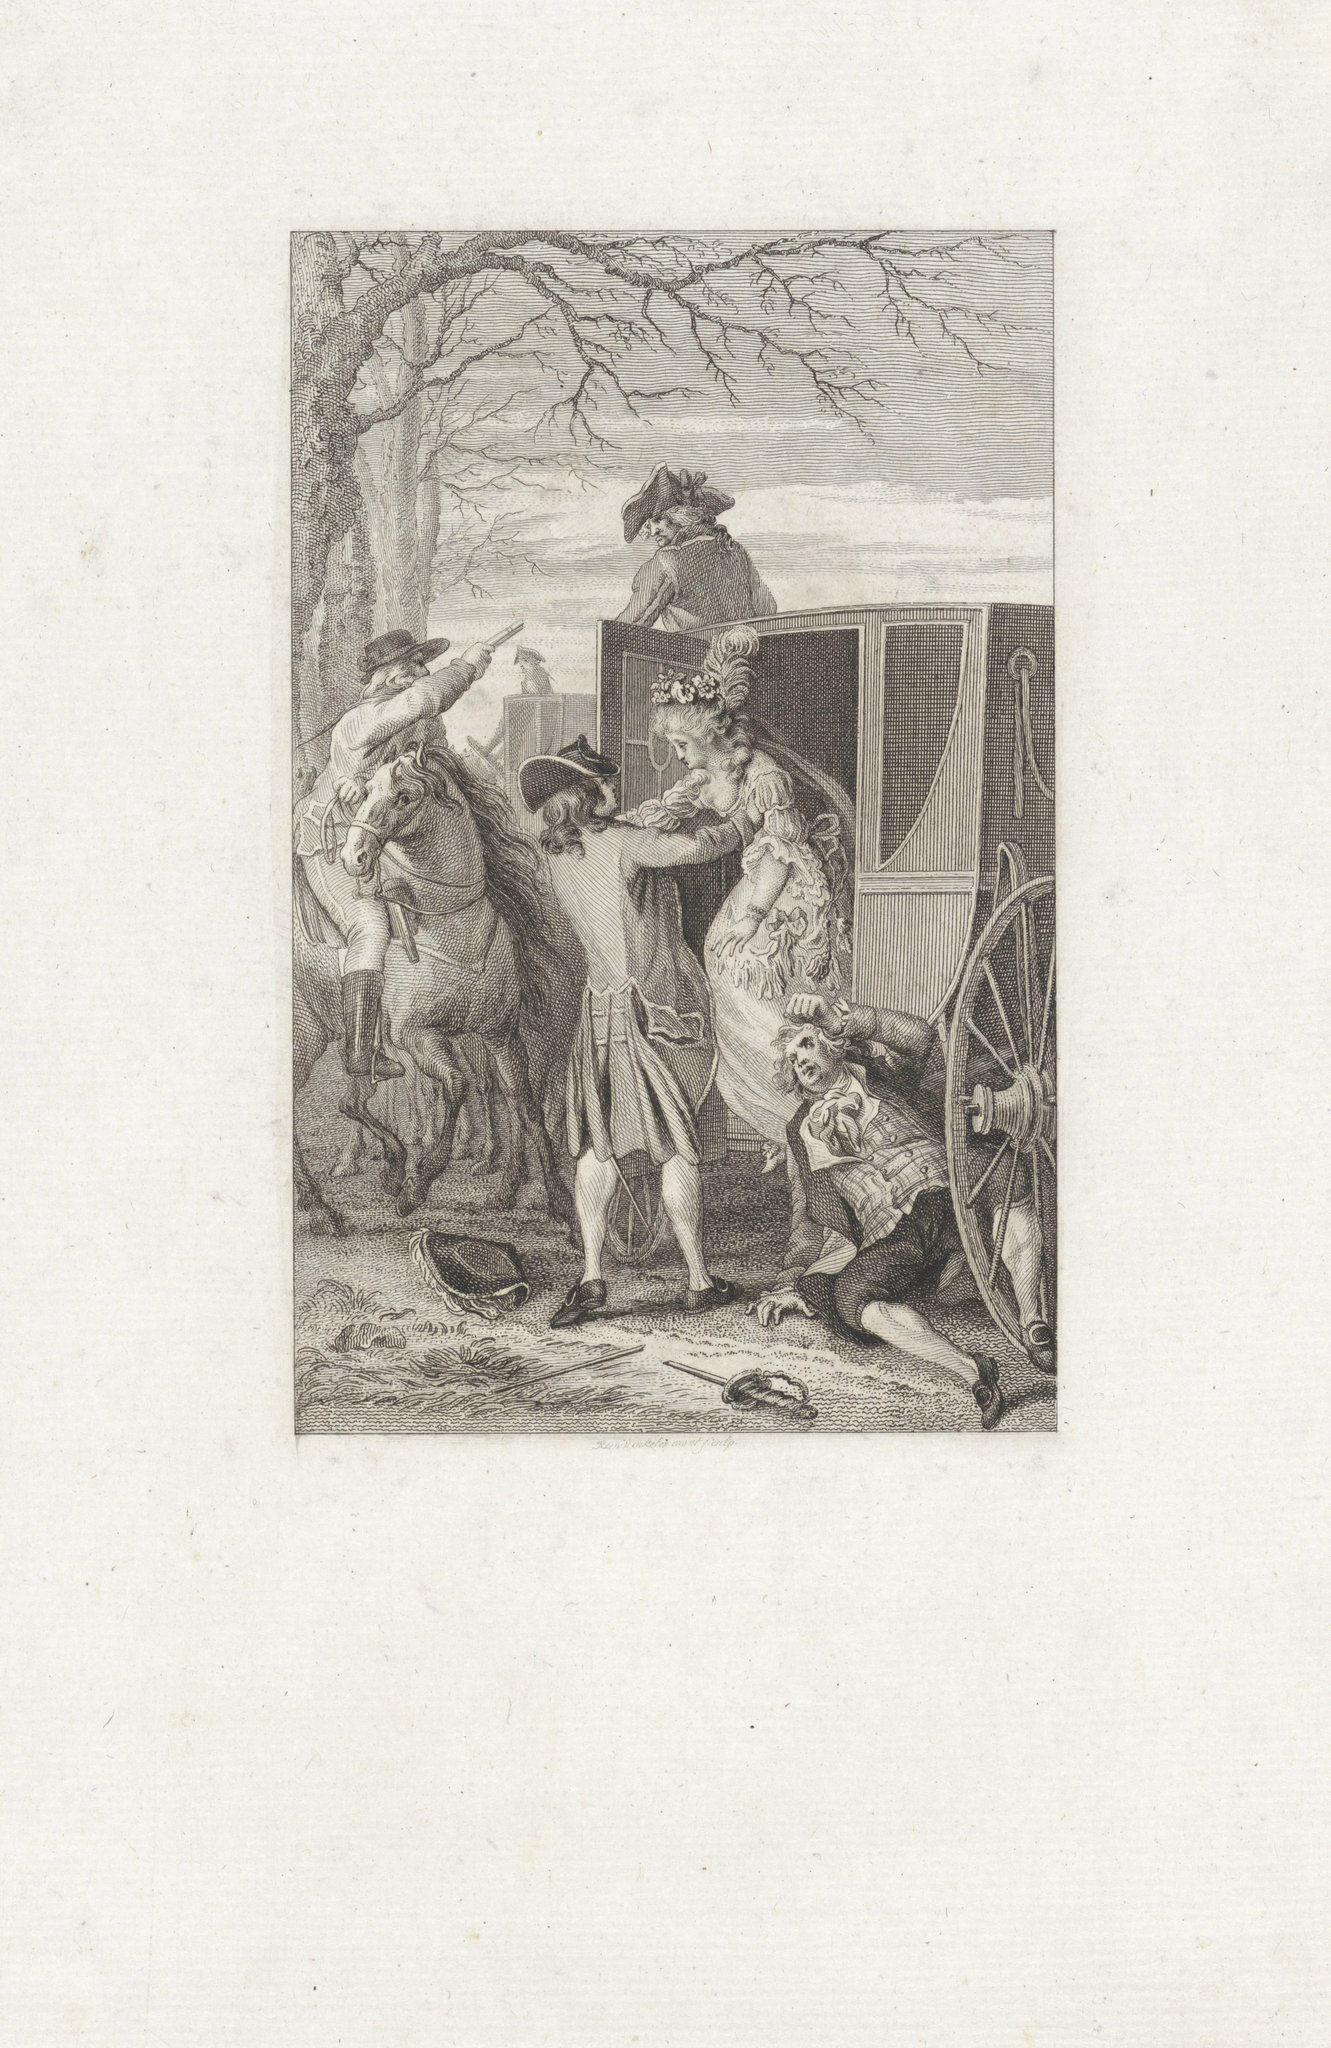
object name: print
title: Strubbelingen rond een koets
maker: reinier vinkeles (i)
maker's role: draughtsman, print maker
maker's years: 1741-1816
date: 1797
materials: paper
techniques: engraving, etching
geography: amsterdam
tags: four-wheeled, animal-drawn vehicle, e.g.: cab, carriage, coach (+ accident, collision, crash ~ traffic and transport), four-wheeled, animal-drawn vehicle, e.g.: cab, carriage, coach, horse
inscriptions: collector's mark: Lugt 240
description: Terwijl de man op de bok van een koets onder vuur wordt gehouden, helpt een heer een dame uit de koets. Op de grond naast hen ligt een man met een van zijn benen tussen de spaken van het voertuig.